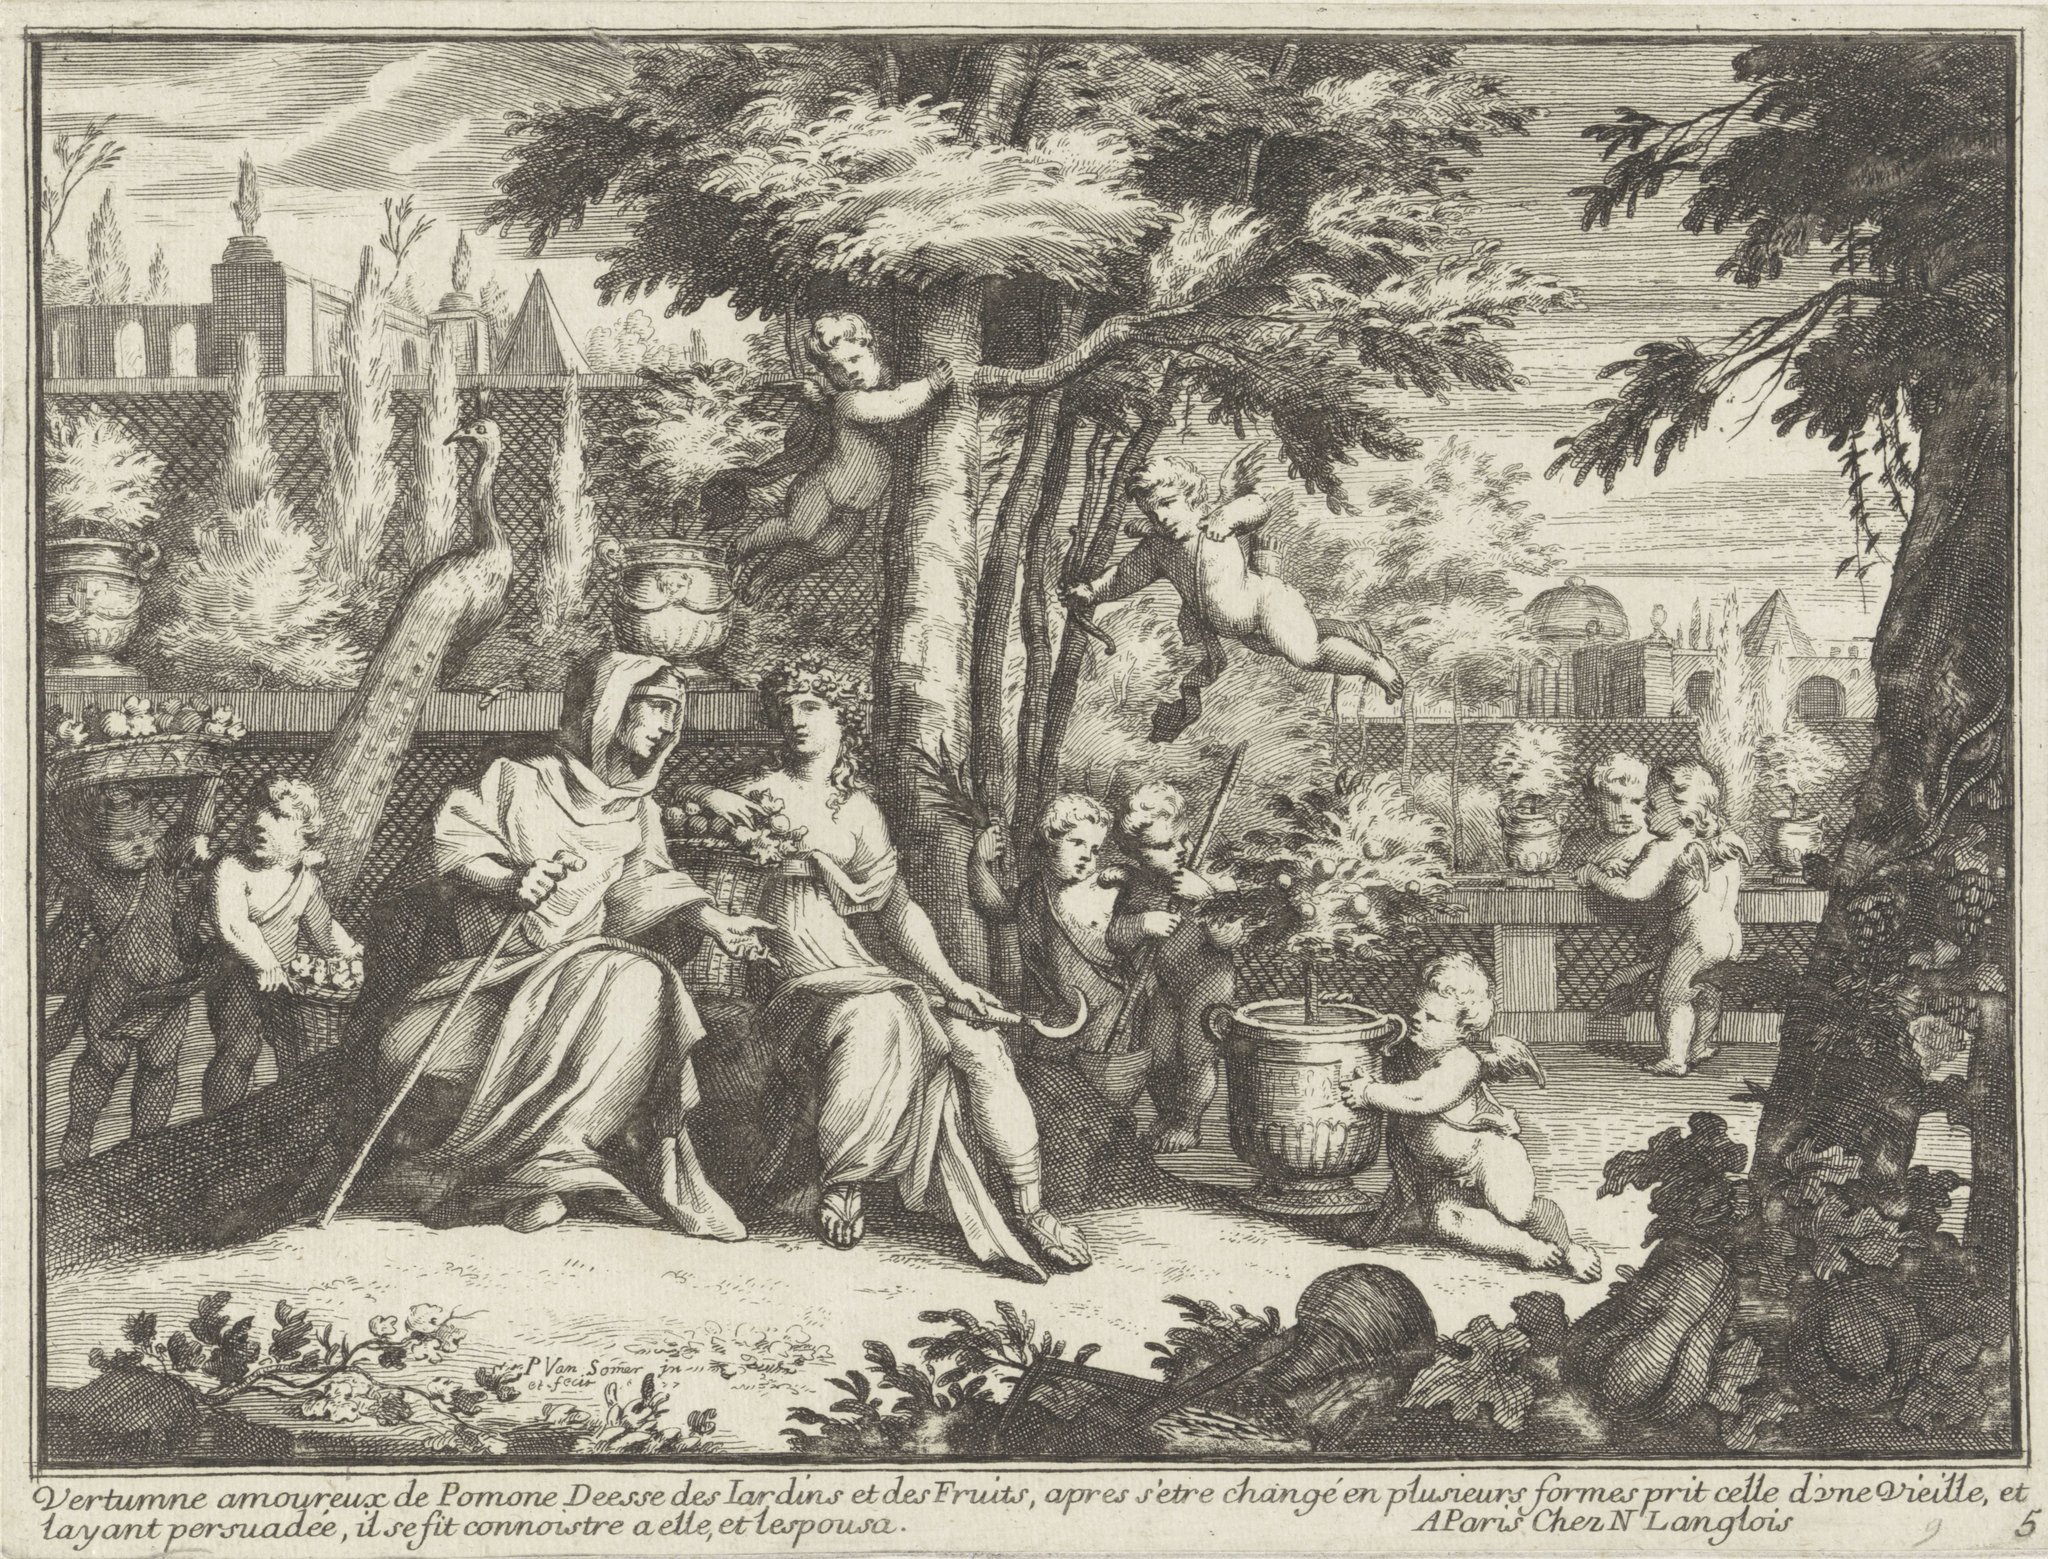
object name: print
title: Mythologische voorstellingen in landschappen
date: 1670-1697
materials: paper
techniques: engraving, etching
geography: paris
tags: ornamental birds: peacock, vertumnus, in the guise of an old woman, wooing pomona, cupids: 'amores', 'amoretti', 'putti'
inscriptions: collector's mark: Lugt 2228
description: Vertumnus buigt zich in de gedaante van een oude vrouw over Pomona. Zij zit onder een boom en steunt haar arm op een mand met vruchten. In haar hand houdt zij een snoeimes. In de tuin waarin zij zitten, staan potten met oranjeboompjes. Op een muur zit een pauw. Op de voorgrond slingert een wijnrank met rijpe vruchten zich in een boom. Putti kijken toe. Onder de afbeelding een verklarende tekst in het Frans. Scène uit Ovidius’ Metamorfosen (Met. XIV, 623-697 en 765-771).